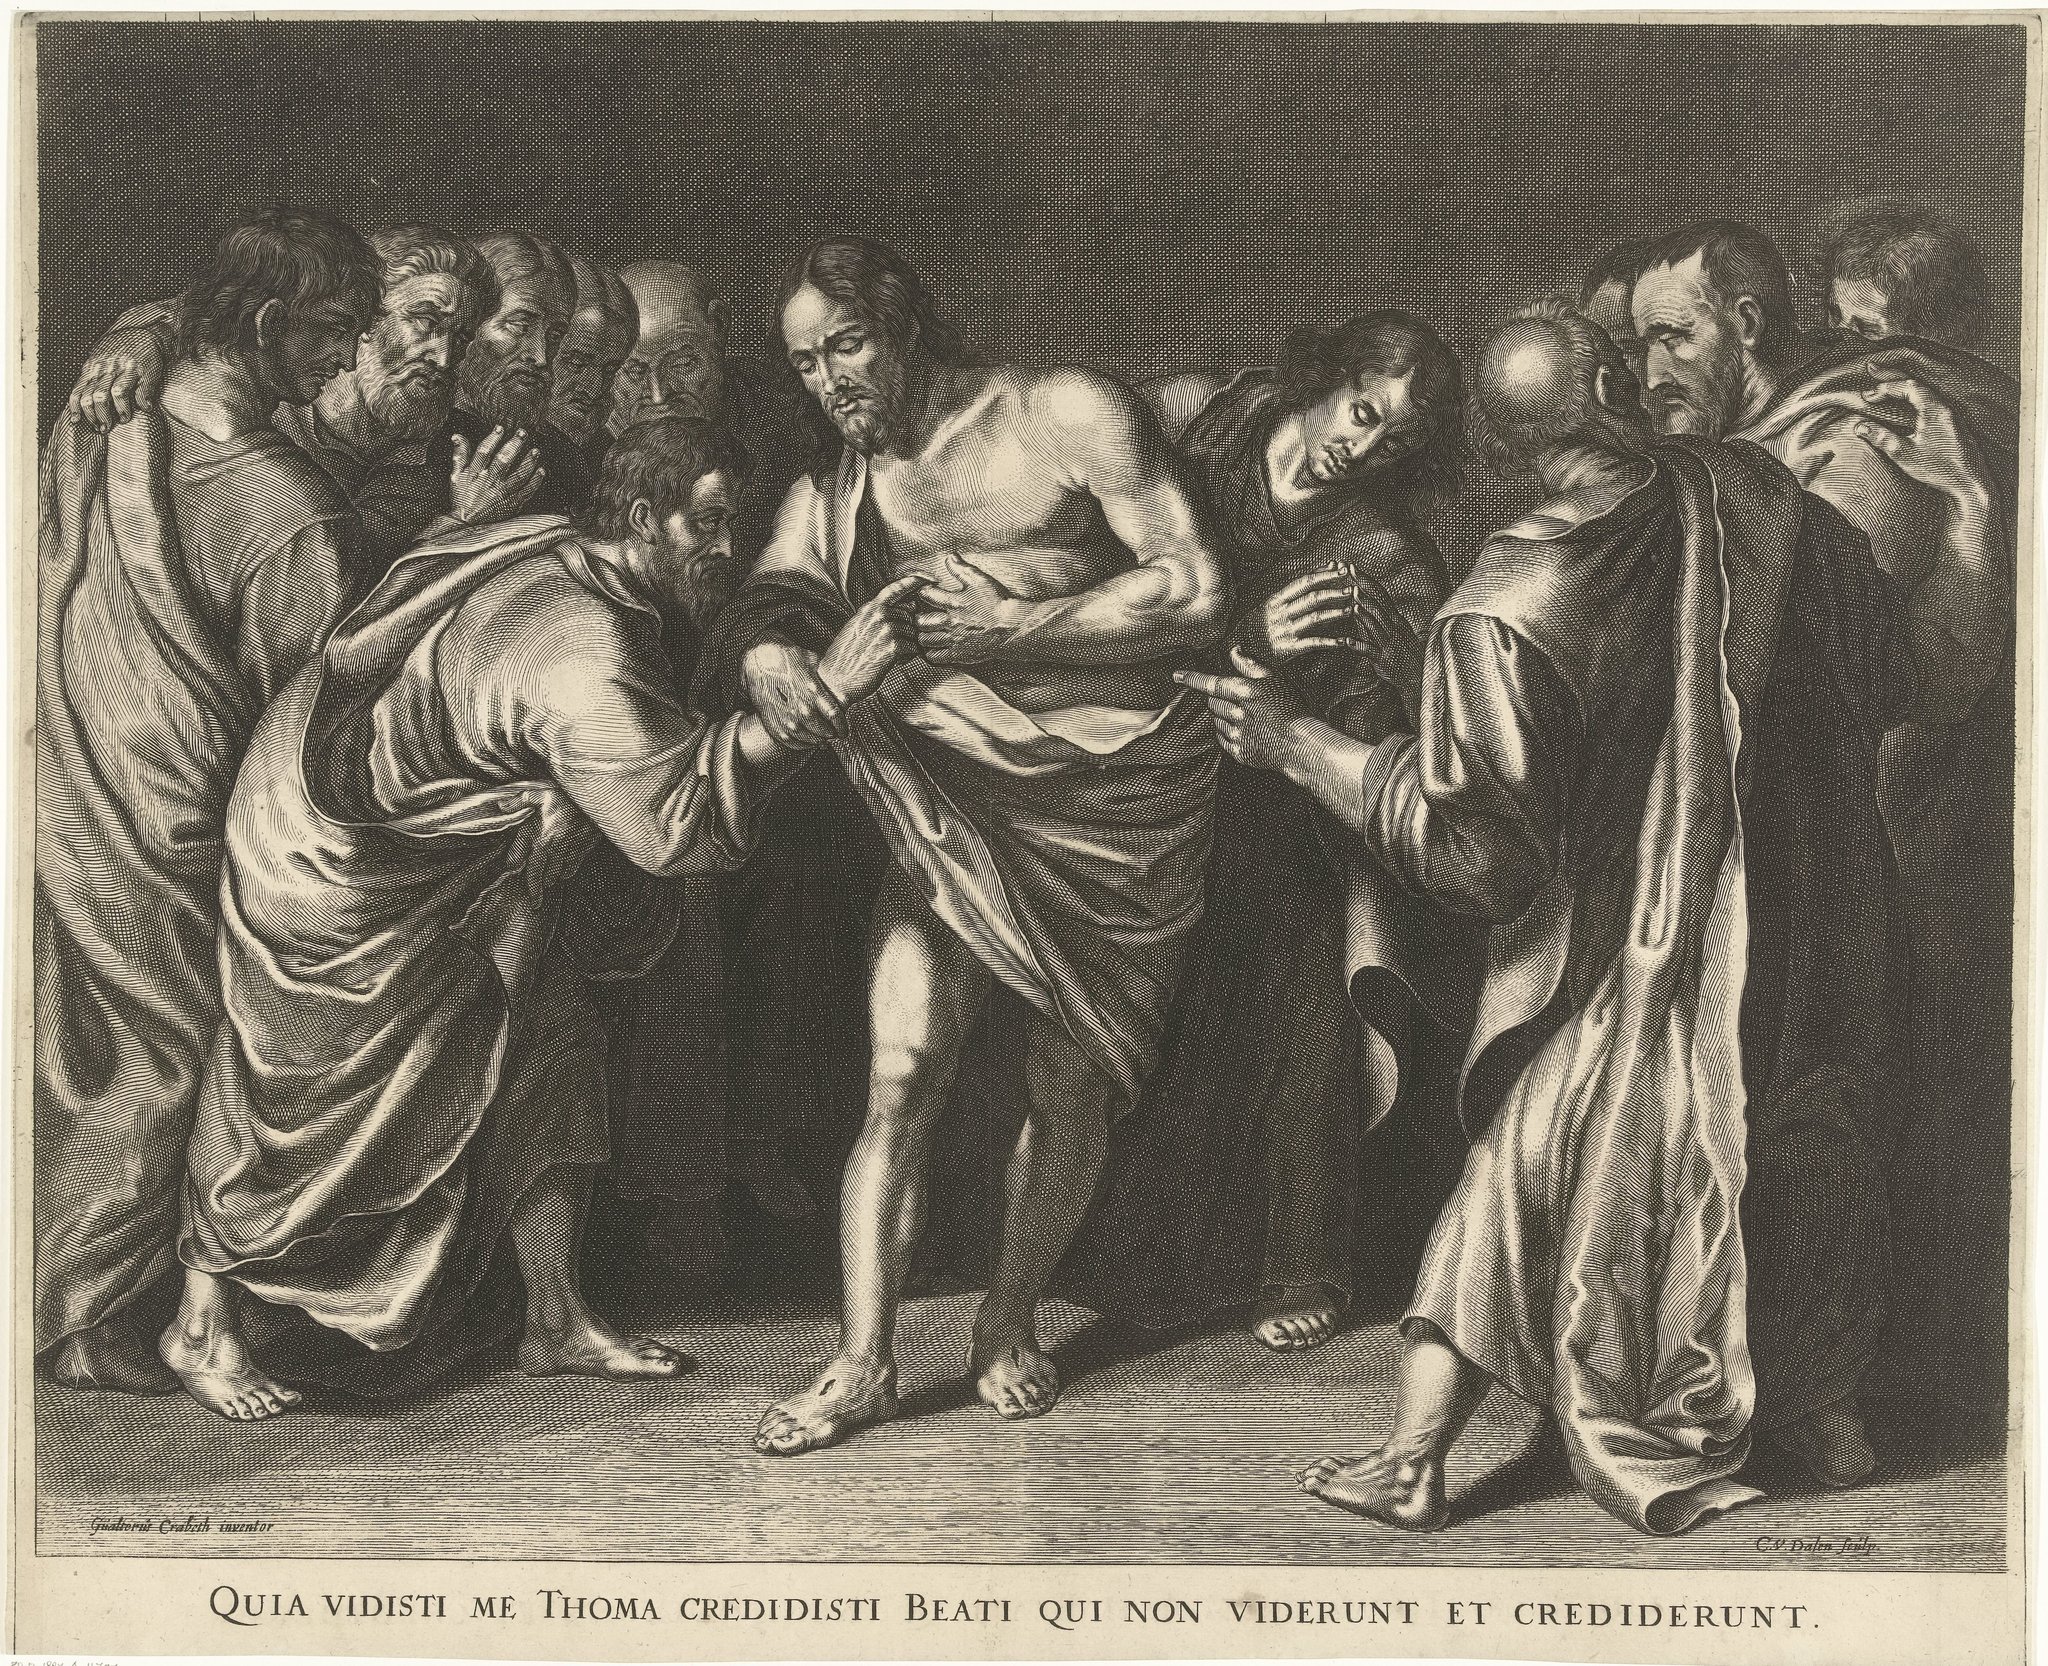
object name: print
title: Quia vidisti me Thoma credidisti beati qui non viderunt et crediderunt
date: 1612-1665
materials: paper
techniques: engraving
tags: thomas touching or stretching out his hands to touch the wound in christ's side, sometimes christ leading thomas' hand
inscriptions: collector's mark: Lugt 2228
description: Christus toont Thomas zijn wonden na de kruisiging in aanwezigheid van de andere apostelen.